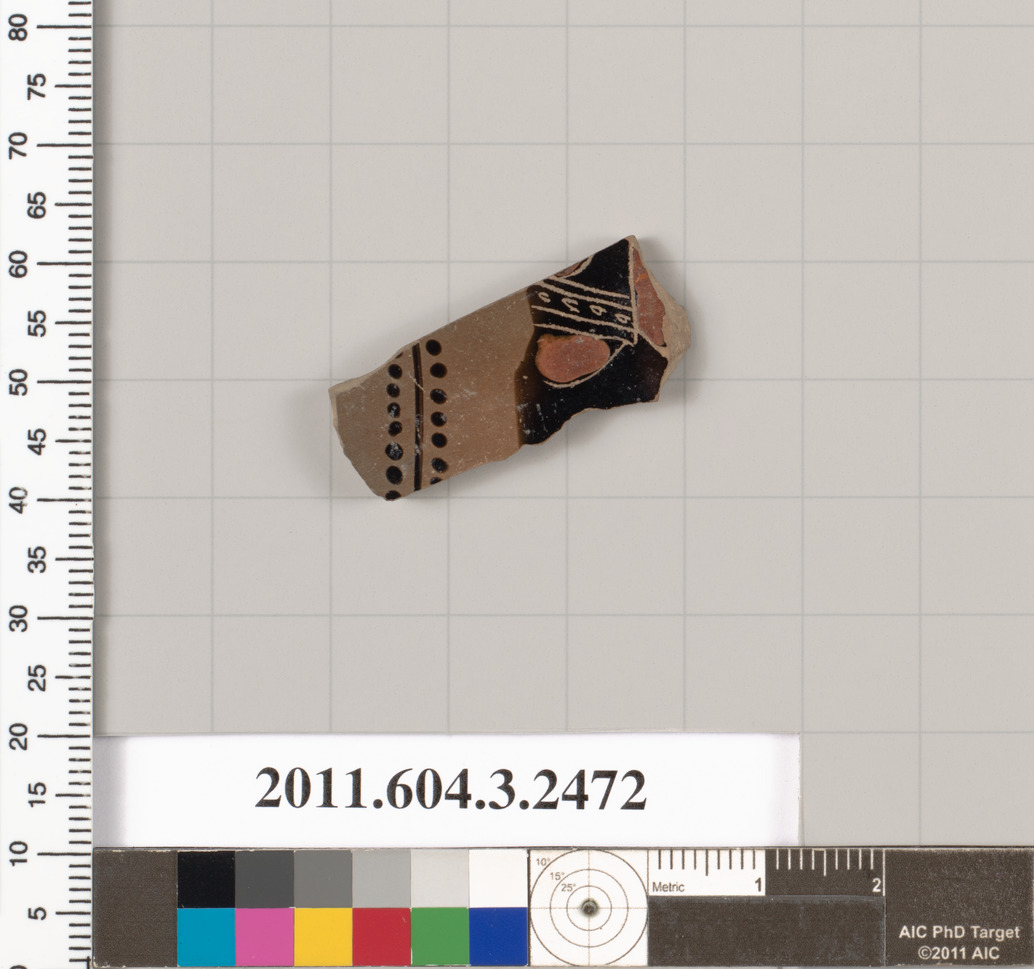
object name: kylix fragment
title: Terracotta fragment of a kylix (drinking cup)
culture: greek, attic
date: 530-510 BCE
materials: terracotta